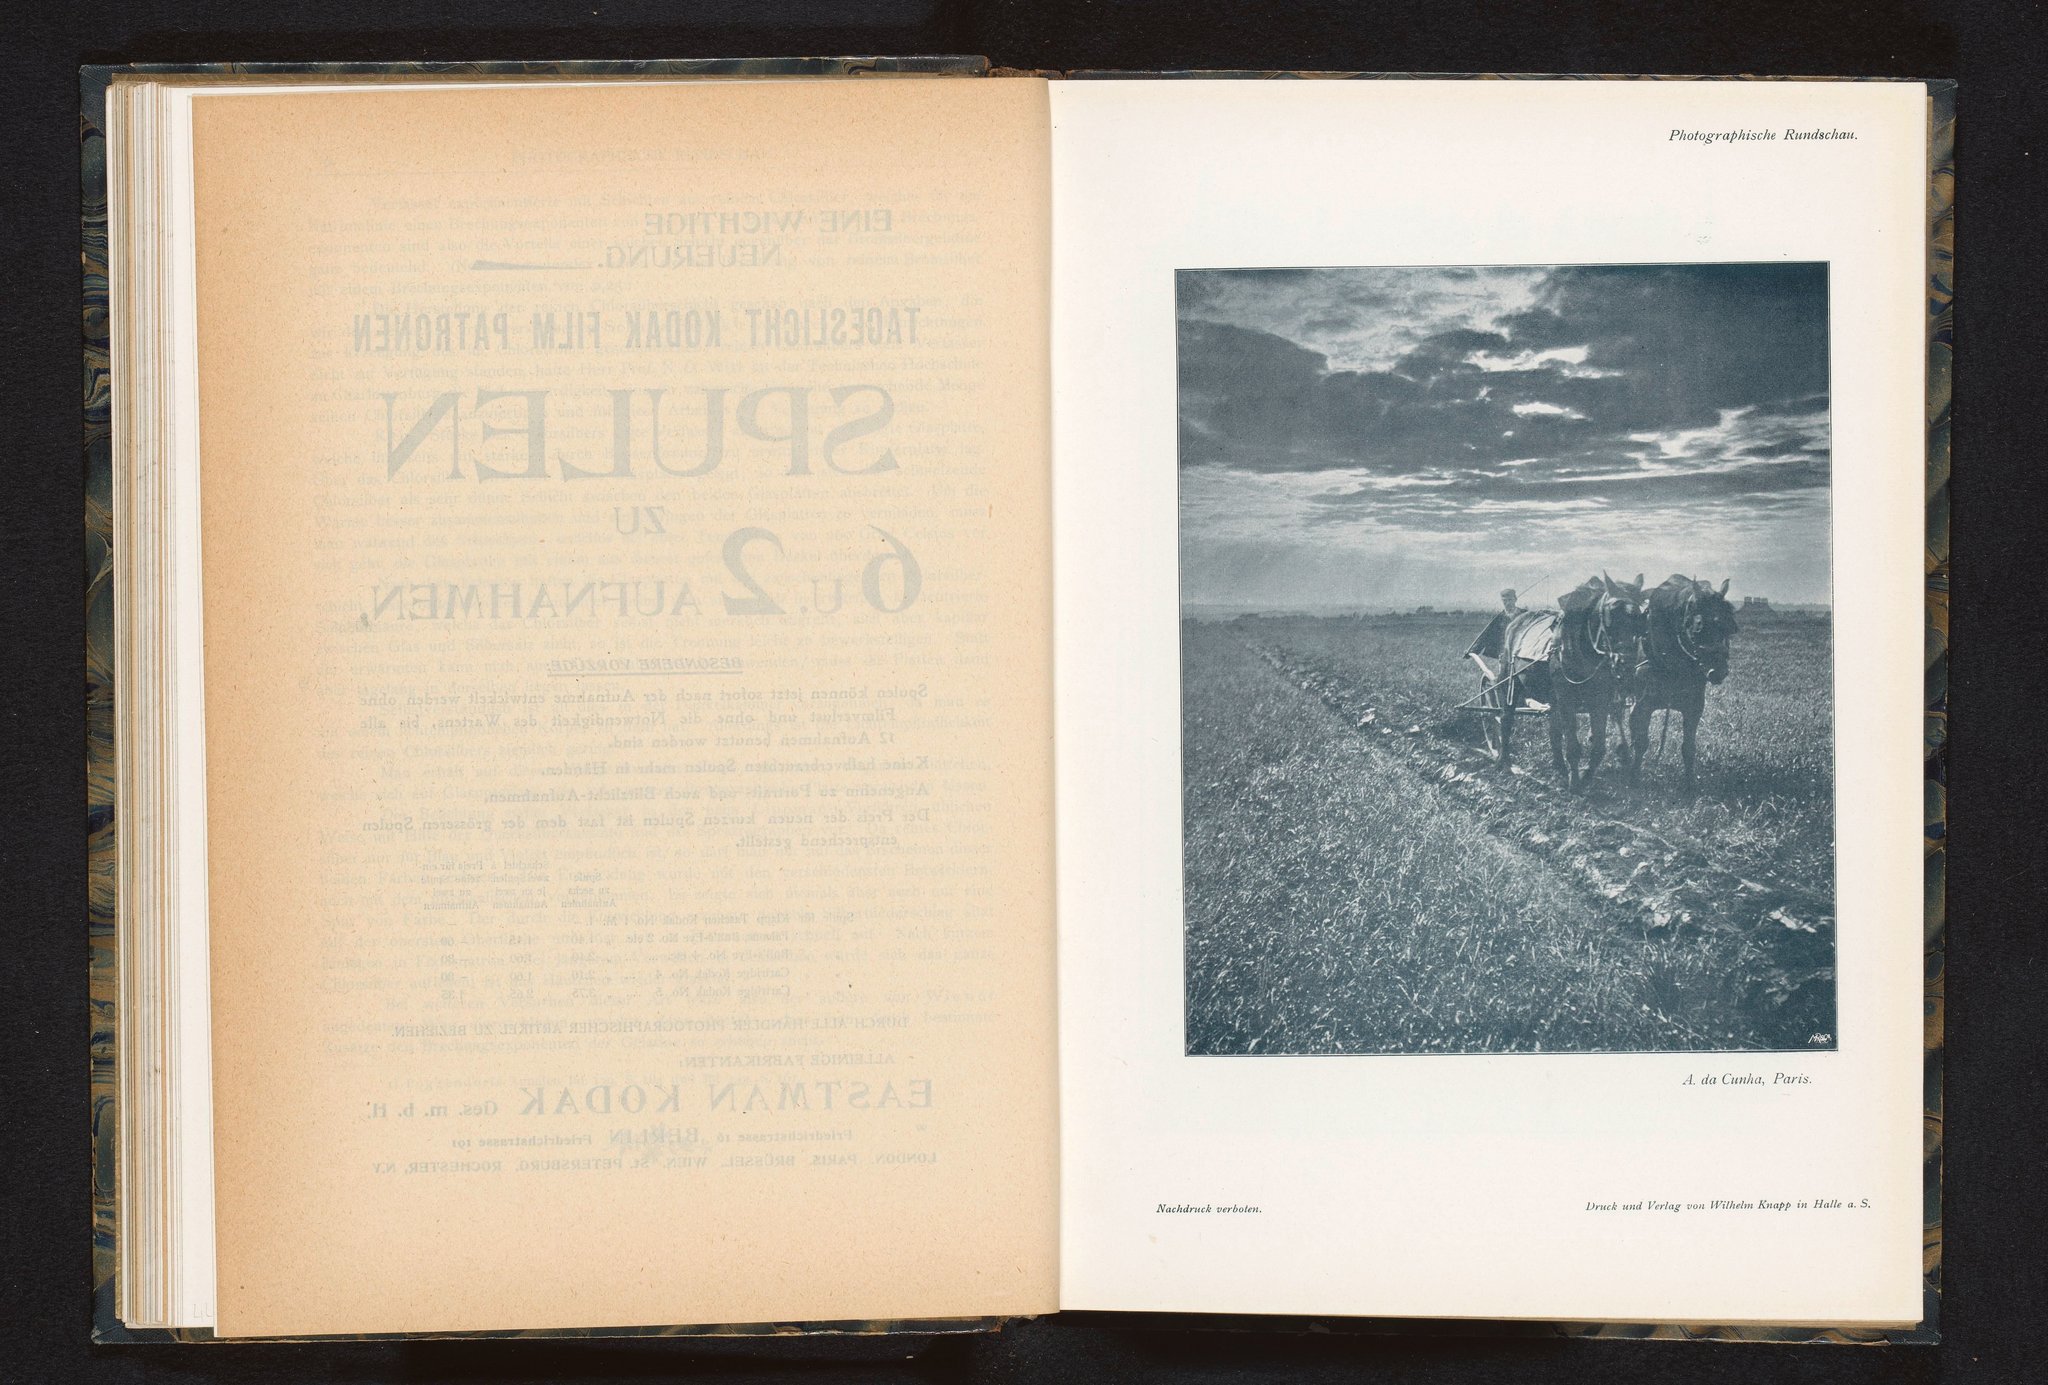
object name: page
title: Gezicht op een weiland met twee paarden voor een span met een onbekende man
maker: arthur g. da cunha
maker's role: fotograaf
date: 1895-1900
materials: paper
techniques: autotype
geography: berlin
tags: horse, two-wheeled vehicle drawn by two animals